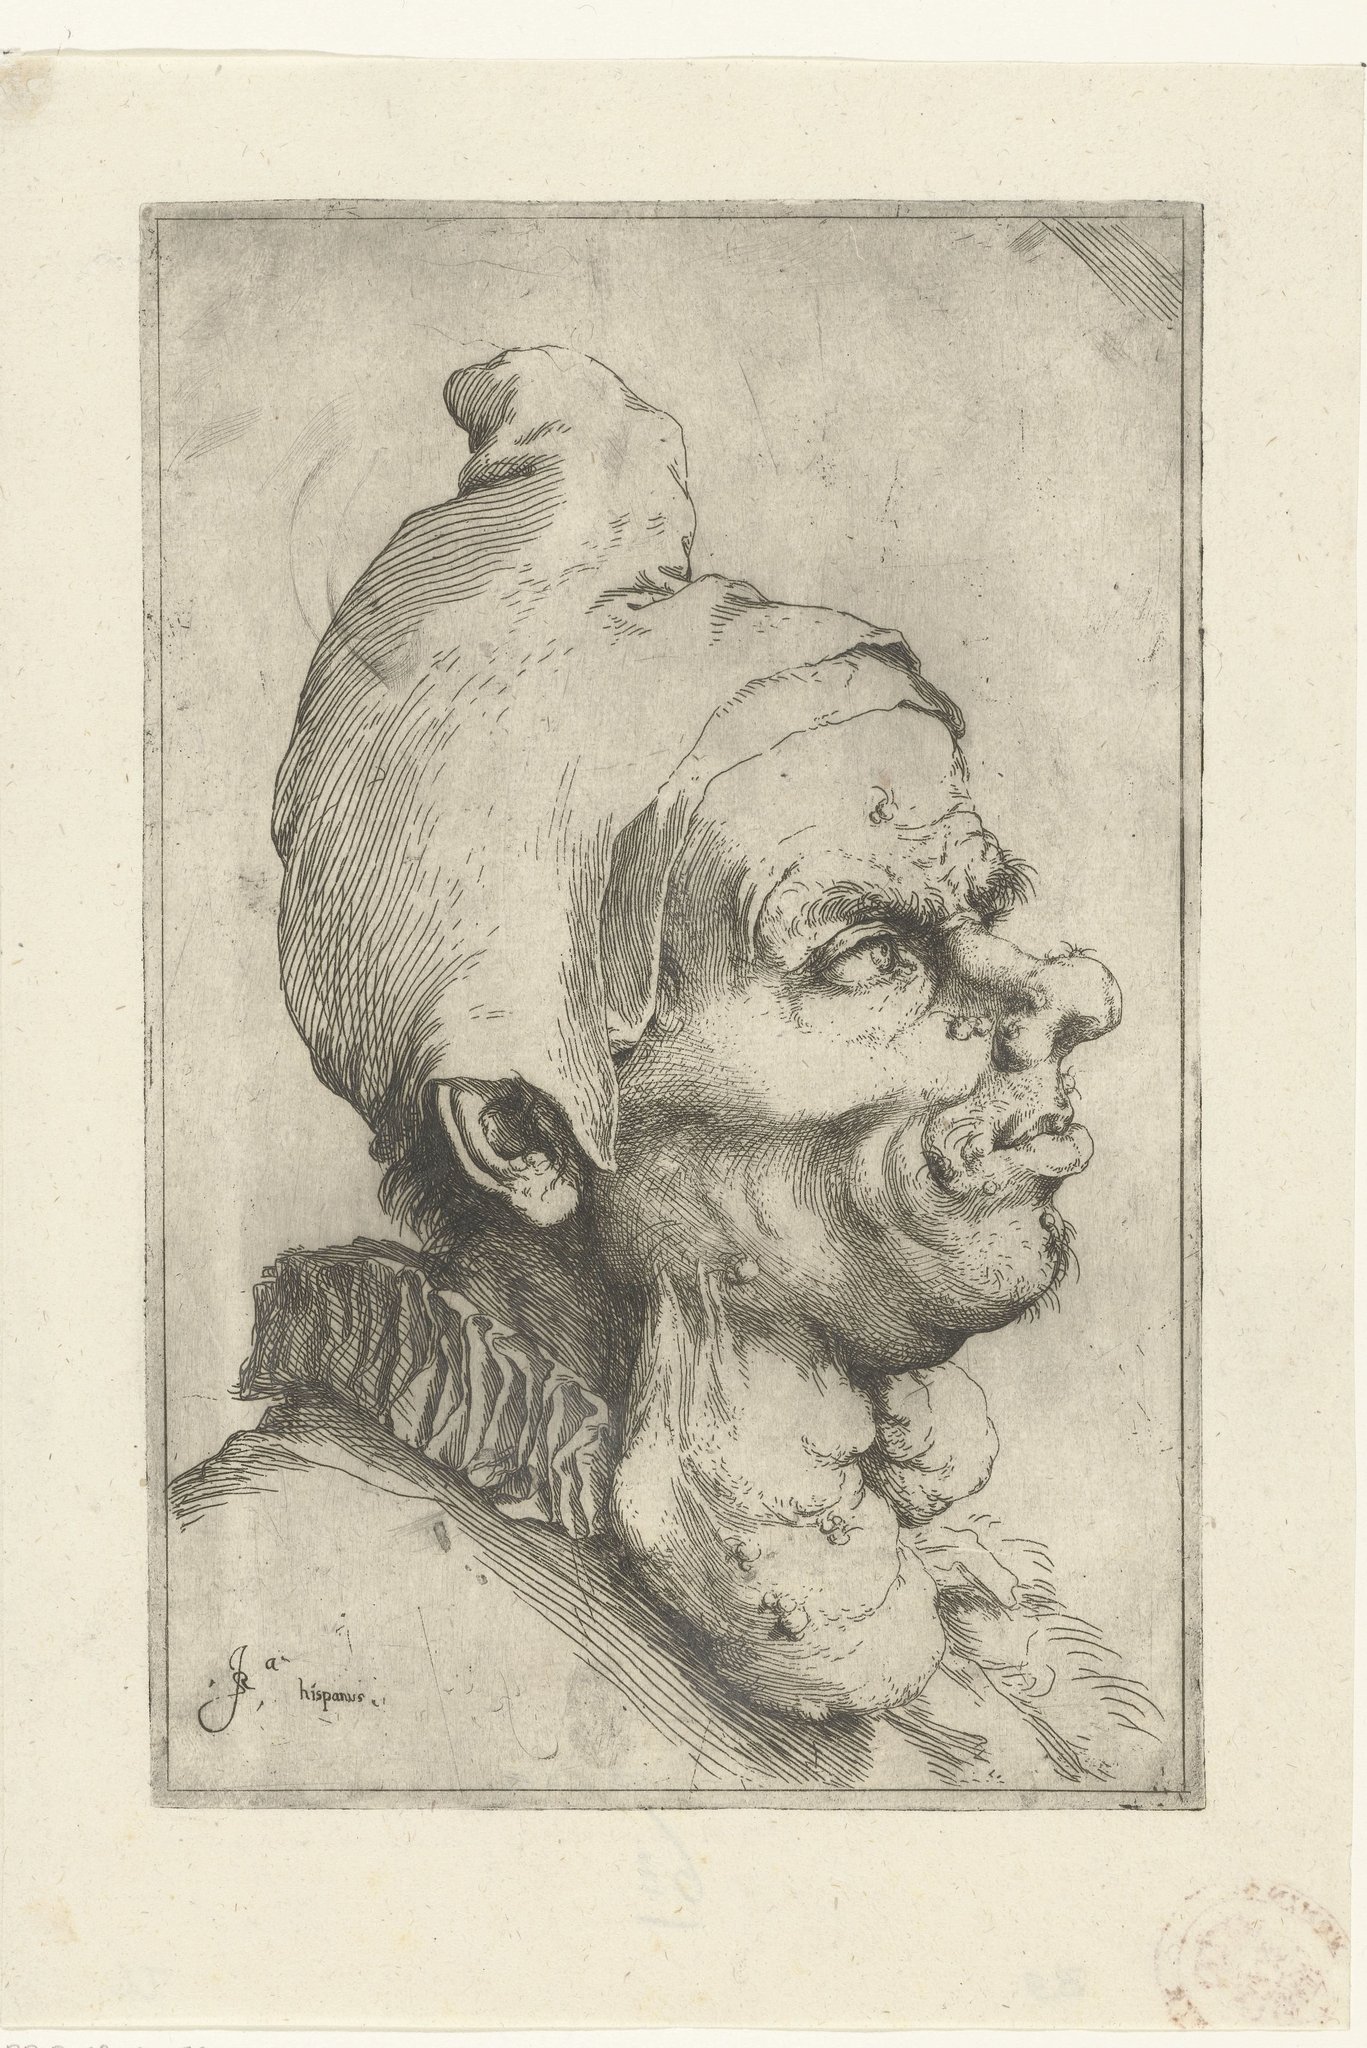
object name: print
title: Groot grotesk hoofd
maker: jusepe de ribera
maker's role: draughtsman, painter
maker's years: 1591-1652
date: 1620-1624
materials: paper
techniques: engraving, etching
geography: naples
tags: disabilities, deformations, diseases affecting parts of the body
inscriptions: collector's mark: Lugt 240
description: Hoofd van een oude man met een frygische muts op, en profil. In zijn hals een groot gezwel.